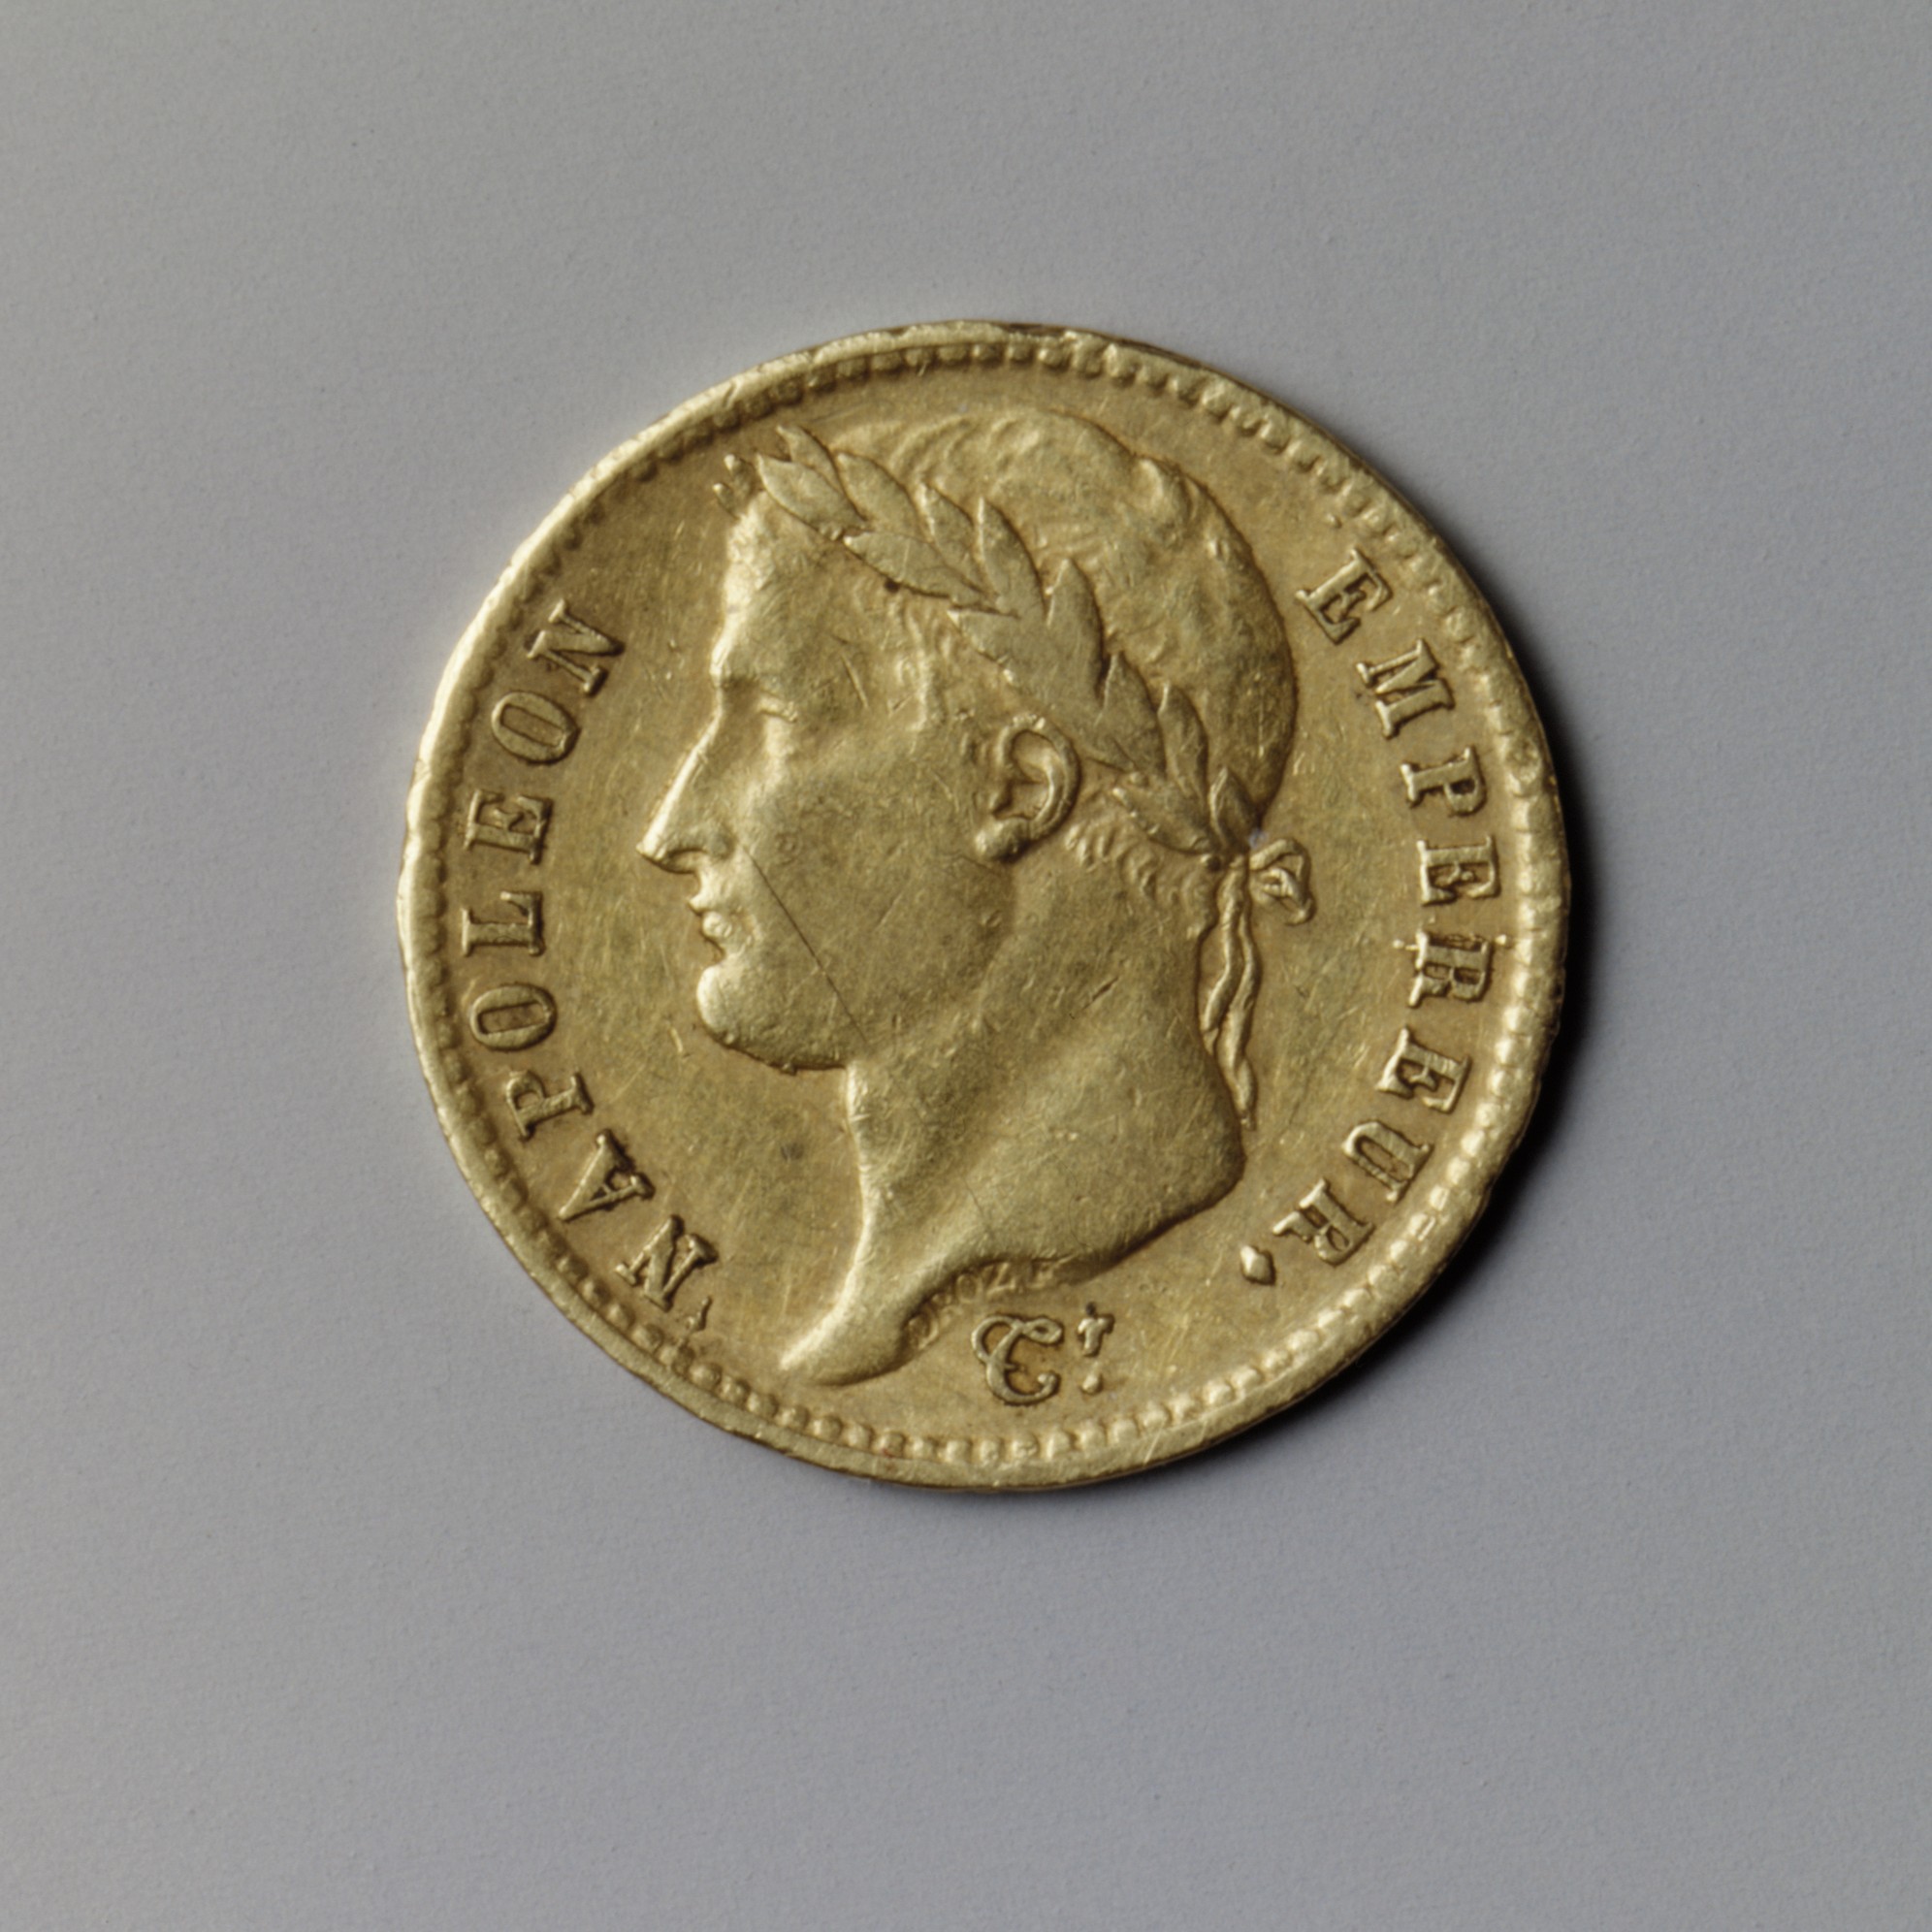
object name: franc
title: 20-franc piece, Napoleon I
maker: jean-pierre droz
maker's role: artist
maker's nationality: french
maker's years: 1746-1823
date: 1811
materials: gold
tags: napoleon i,profiles